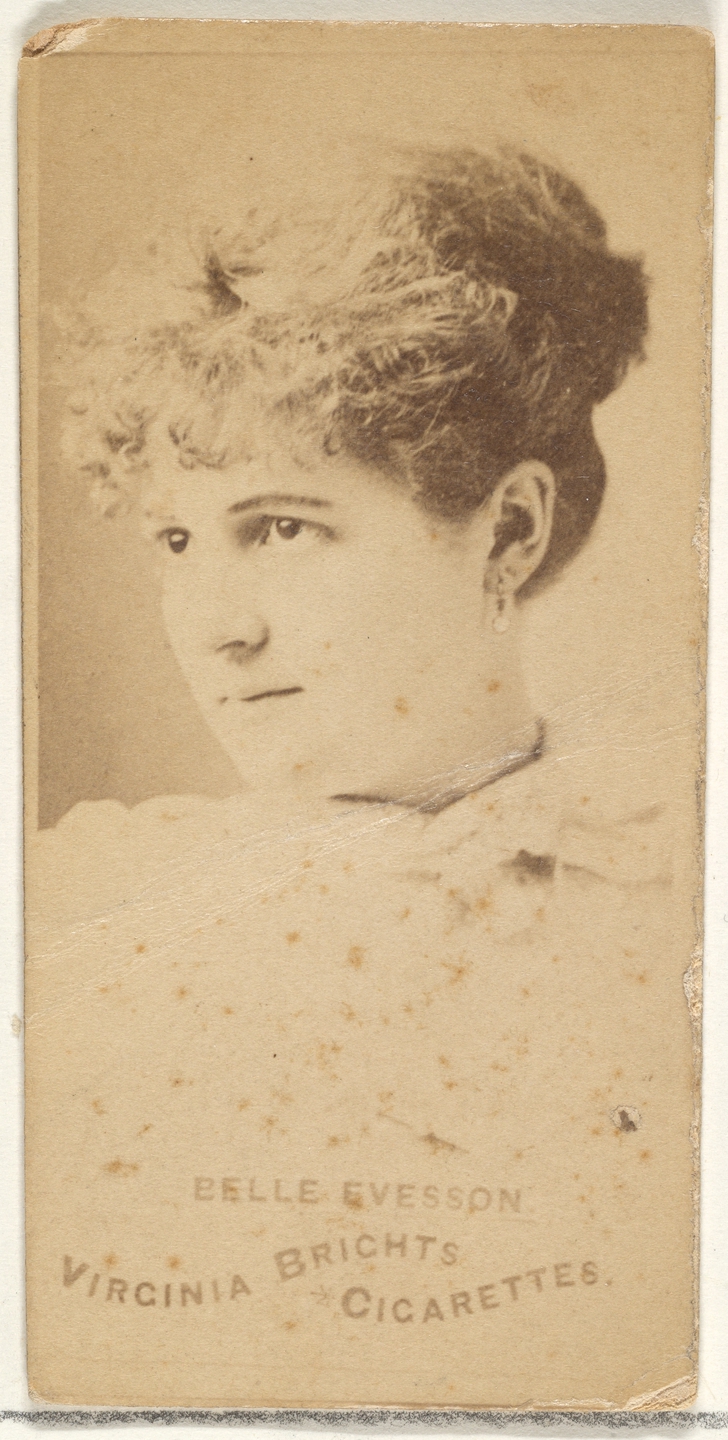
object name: photograph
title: Belle Evesson, from the Actors and Actresses series (N45, Type 1) for Virginia Brights Cigarettes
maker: allen & ginter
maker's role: publisher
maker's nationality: american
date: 1888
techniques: albumen silver print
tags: portraits,women,actresses